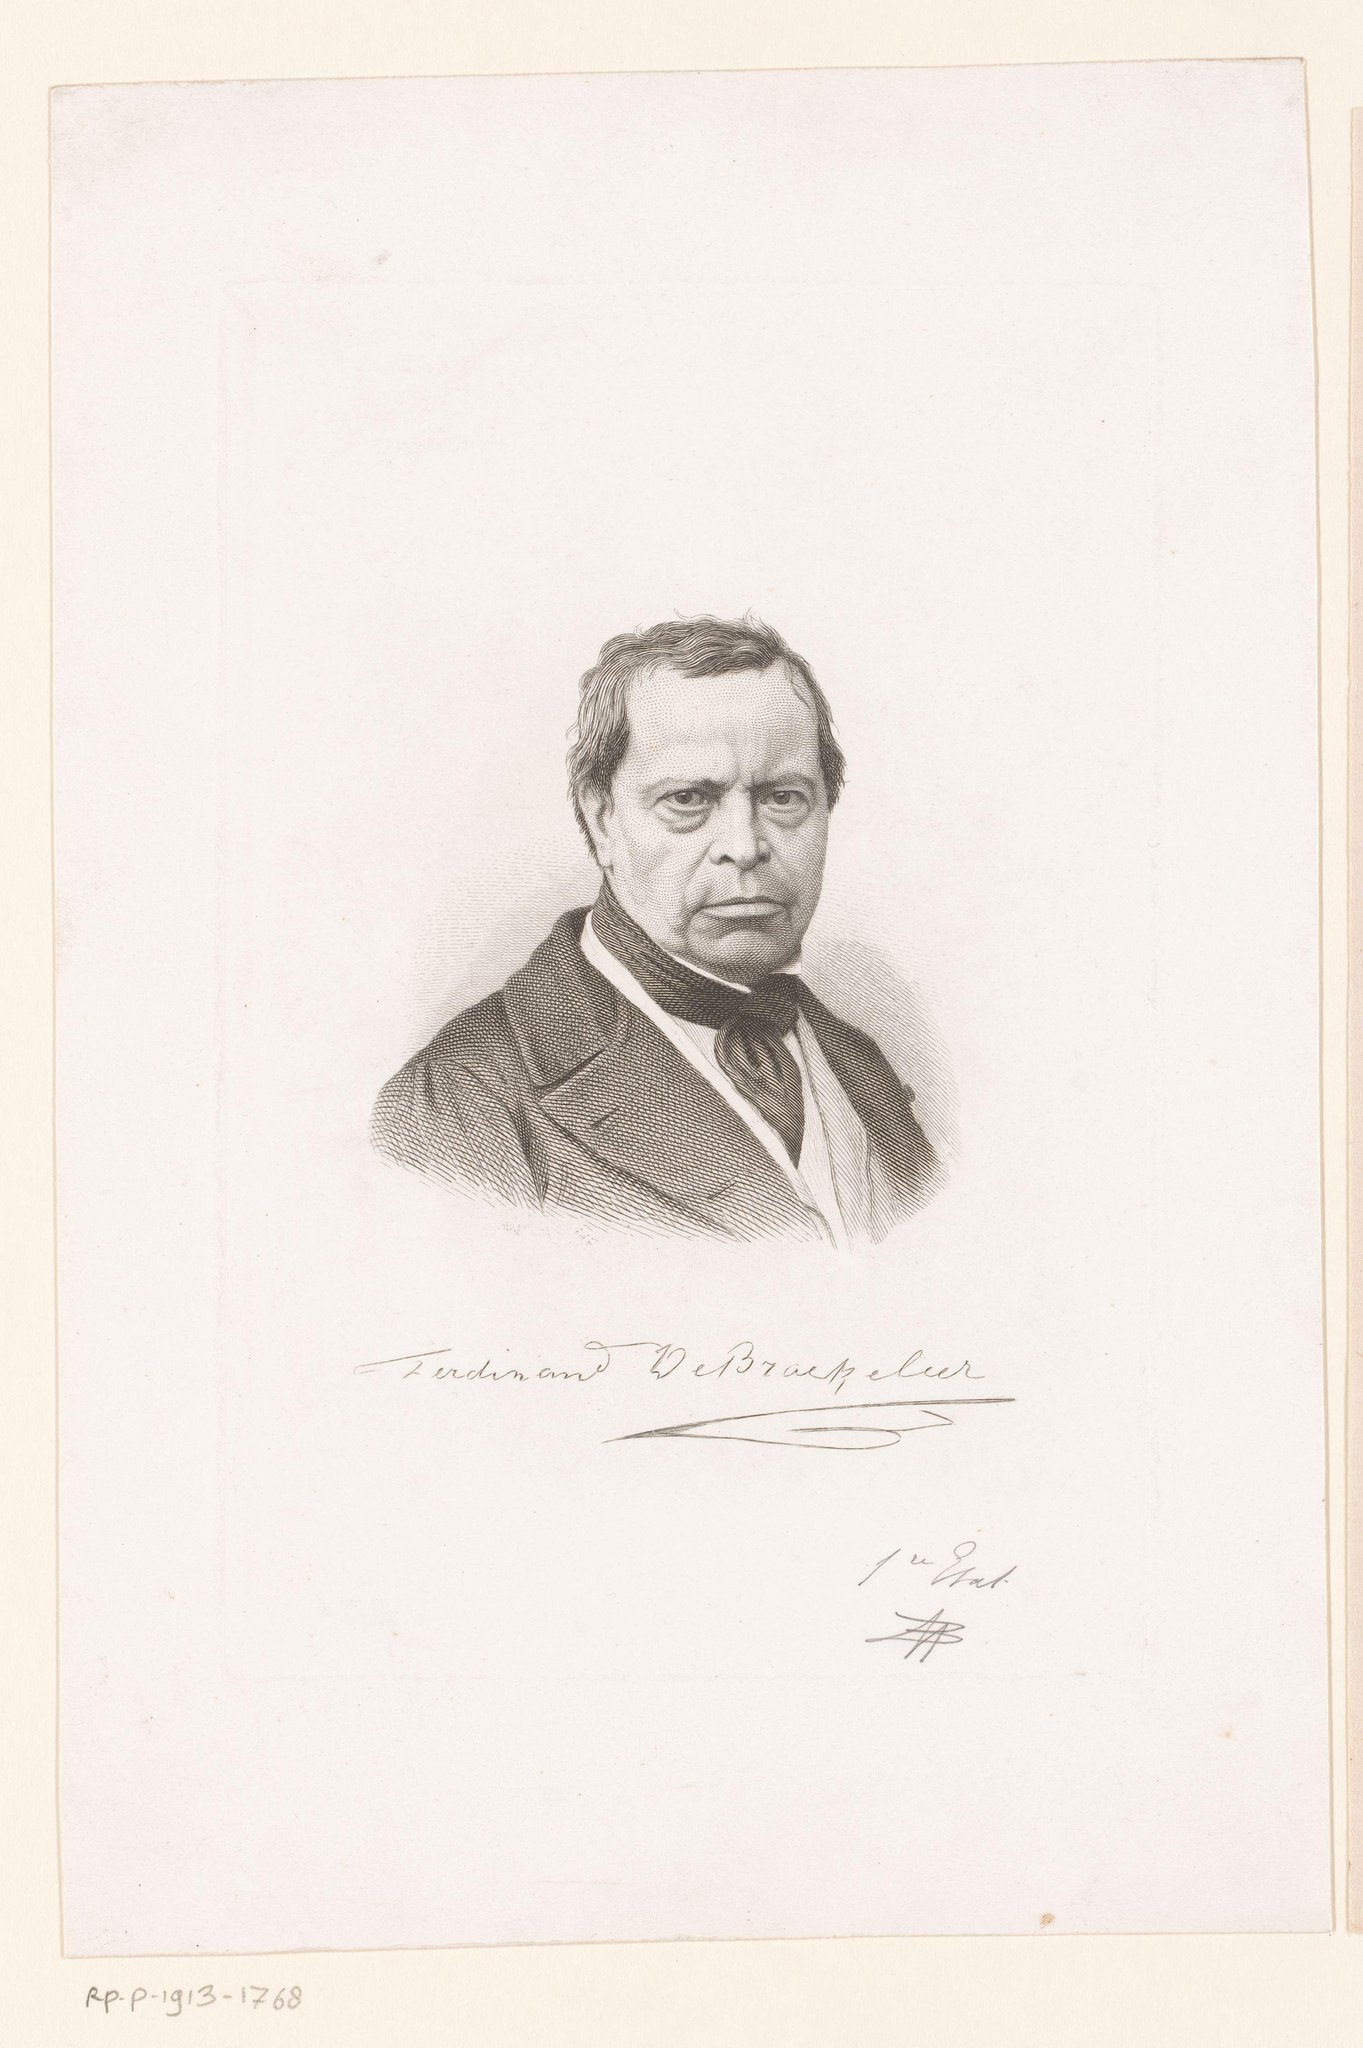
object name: print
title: Ferdinand De Braekeleer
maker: jean baptiste pierre michiels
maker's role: print maker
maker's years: 1821-1890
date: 1831-1890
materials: paper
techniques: etching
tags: antwerp, print maker, draughtsman, ferdinand de braekeleer (i), historical persons, portrait, self-portrait of painter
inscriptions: collector's mark: Lugt 2228, inscription: ‘1e Etat’